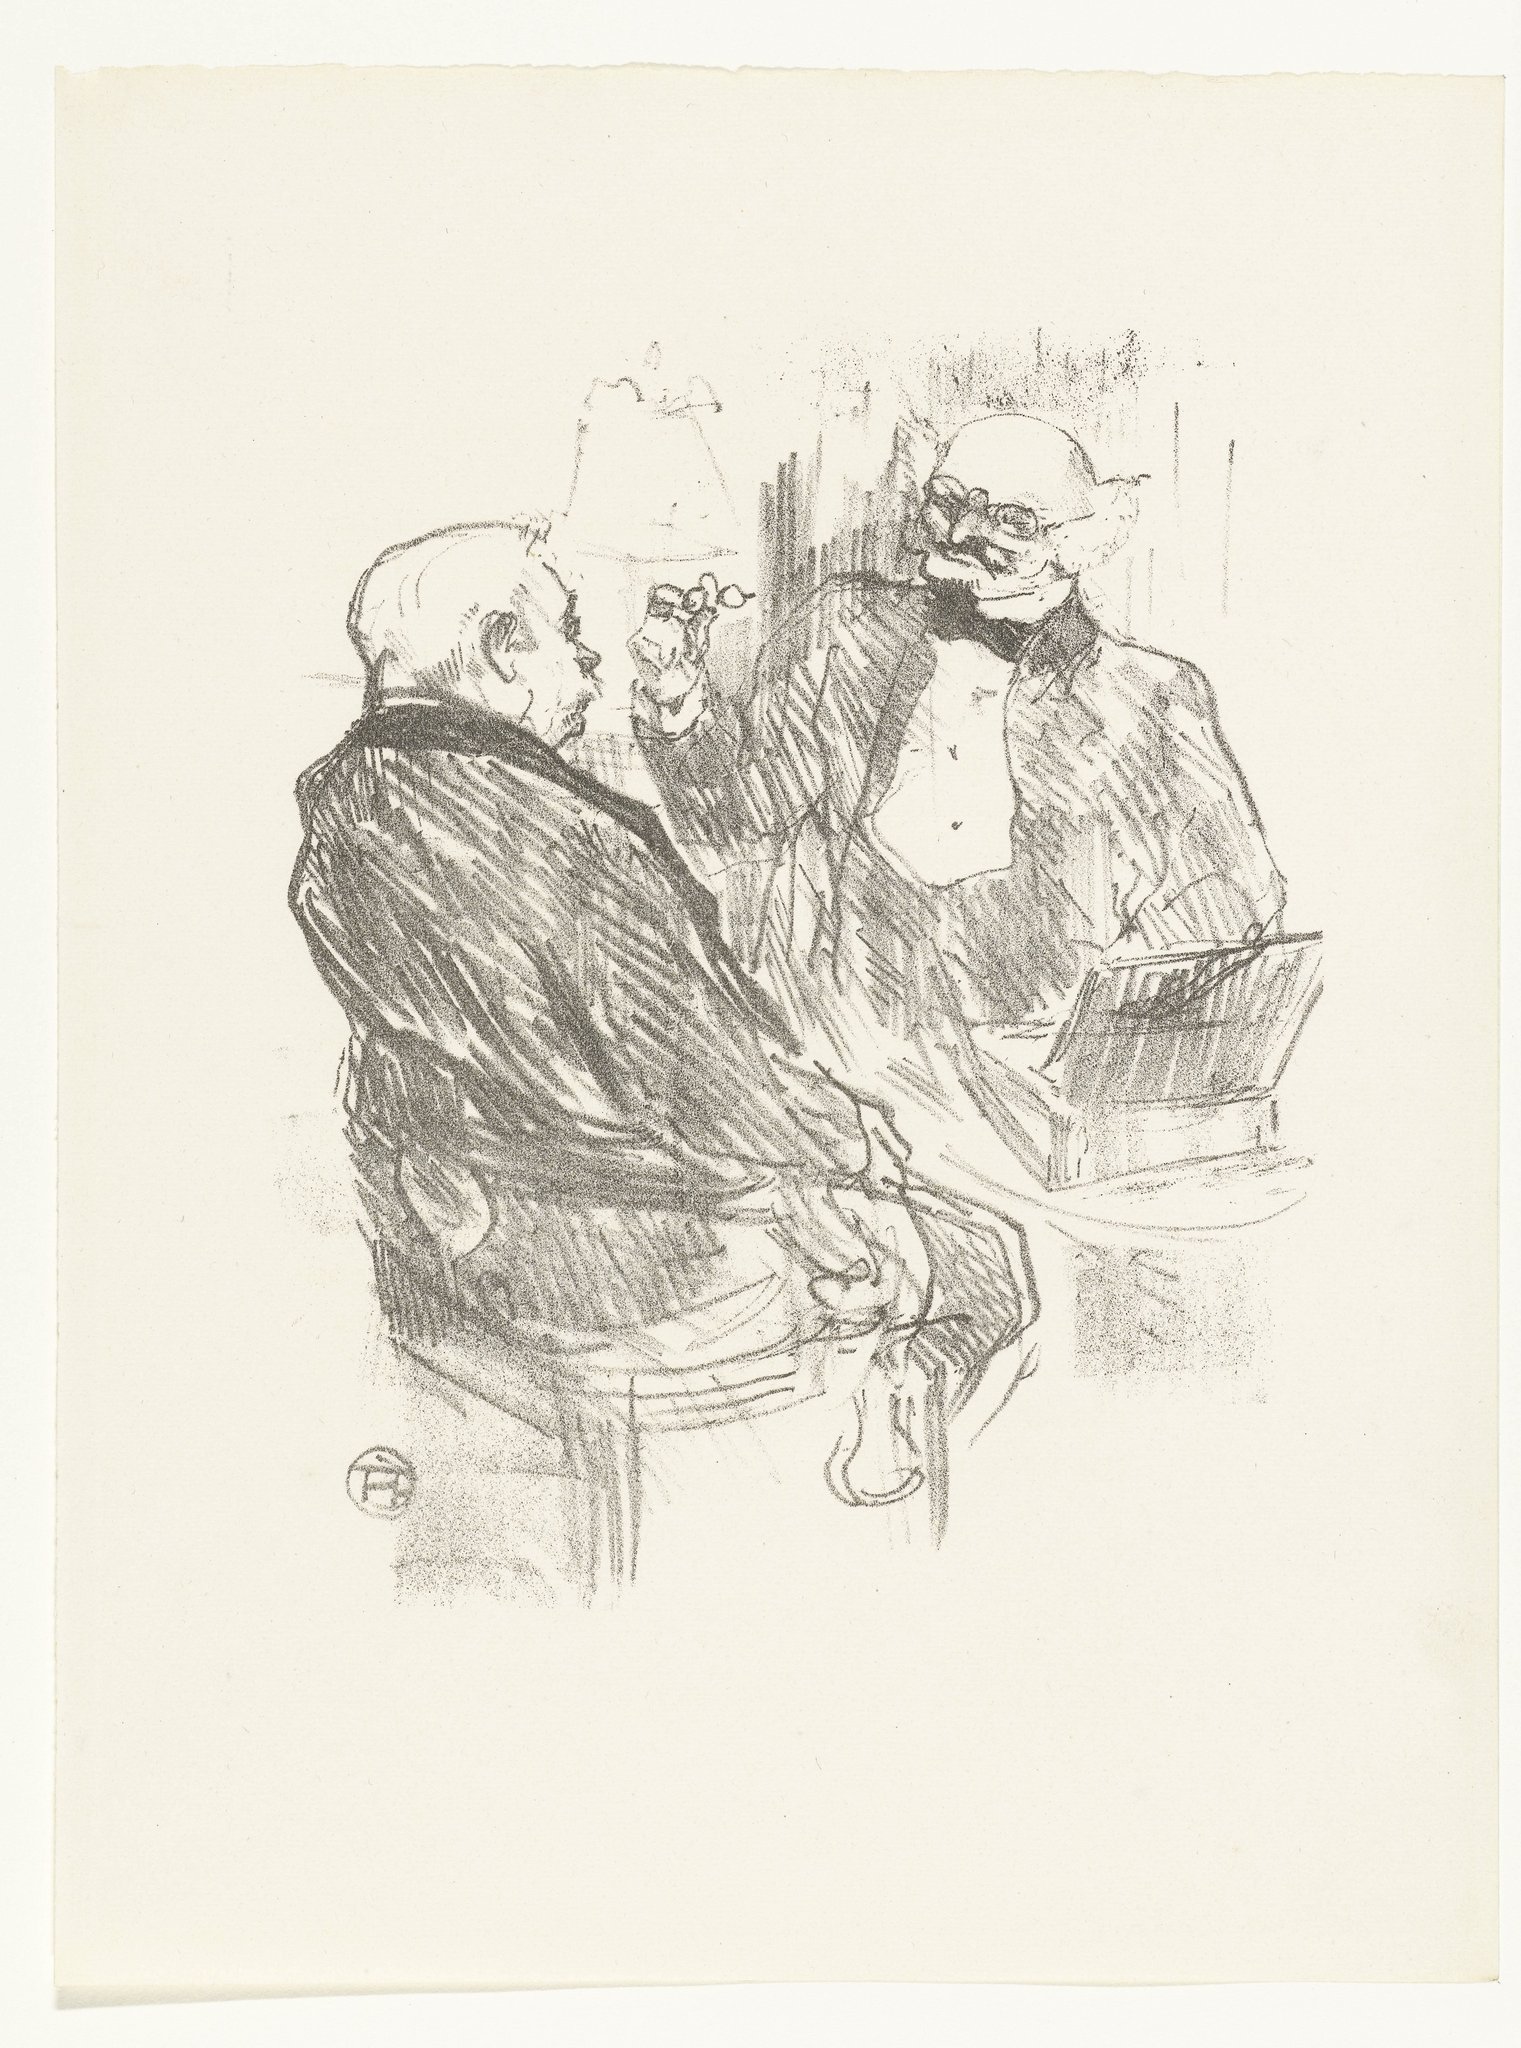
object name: book illustration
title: Georges Clemenceau en oogarts Mayer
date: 1897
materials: paper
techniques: lithograph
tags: paris, politician, eyeglasses, spectacles, spectacle-maker, optician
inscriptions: collector's mark: Lugt 2228, collector's mark: Lugt 2760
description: Illustratie voor Georges Clémenceau, Au Pied du Sinaï, Henri Floury (uitgever), Parijs, april 1898, plaat 7. Lithografie uit de Regular book edition 1898, gedrukt in zwart op velijnpapier, oplage van 355 exemplaren met 11 verschillende illustraties (Wittrock 1985, p. 464).